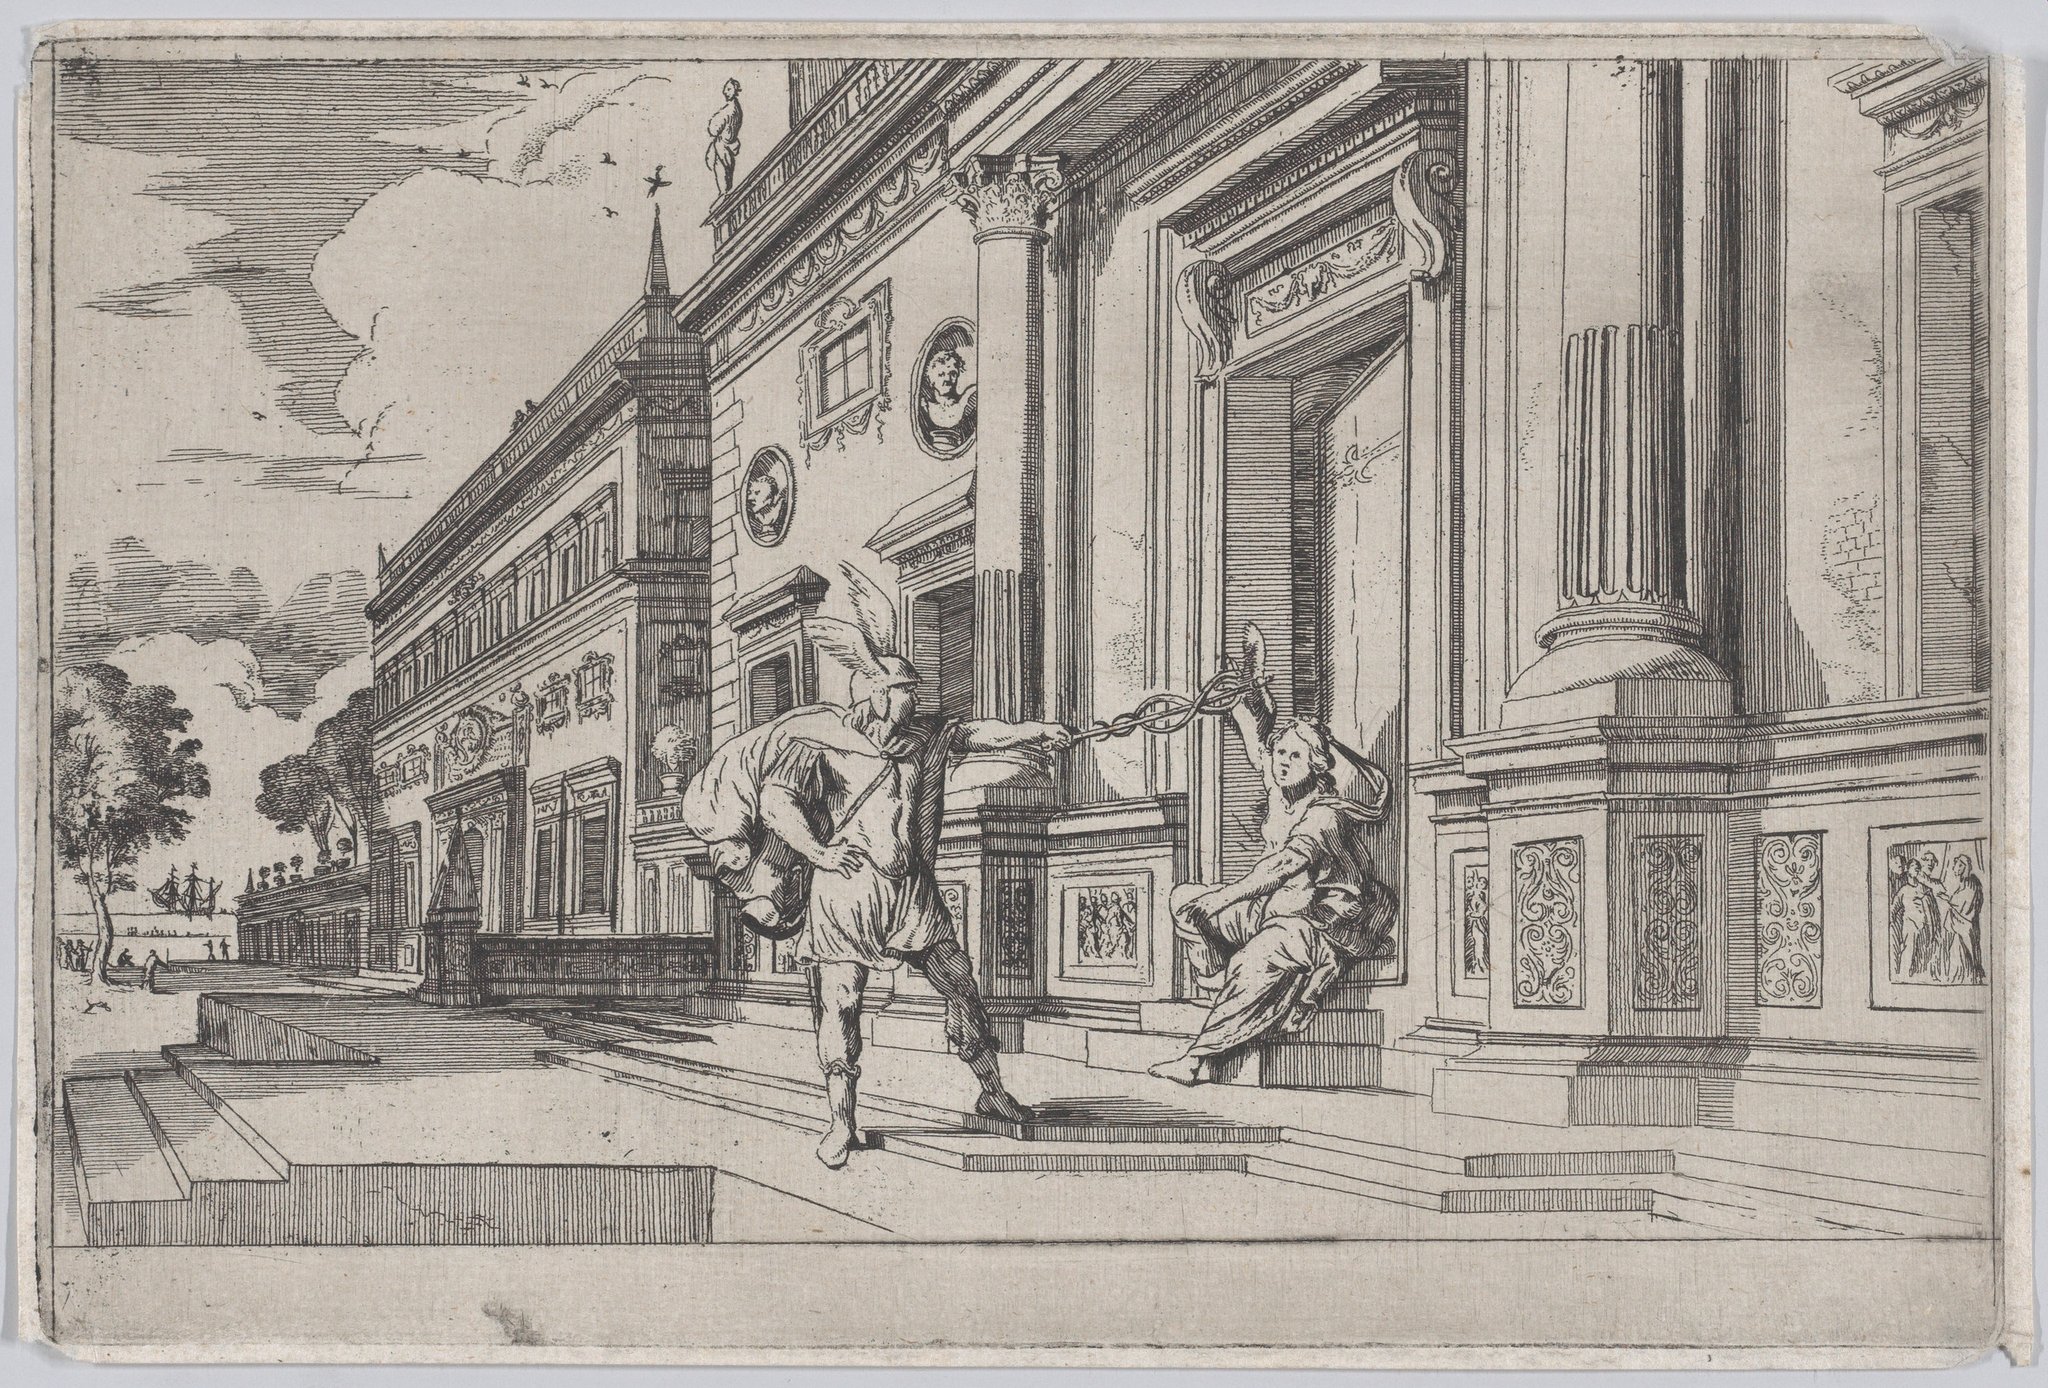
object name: print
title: Plate 24: Mercury and Aglauros, from 'Ovid's Metamorphoses'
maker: johann wilhelm baur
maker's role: artist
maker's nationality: german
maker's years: 1607-1642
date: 1641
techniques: etching